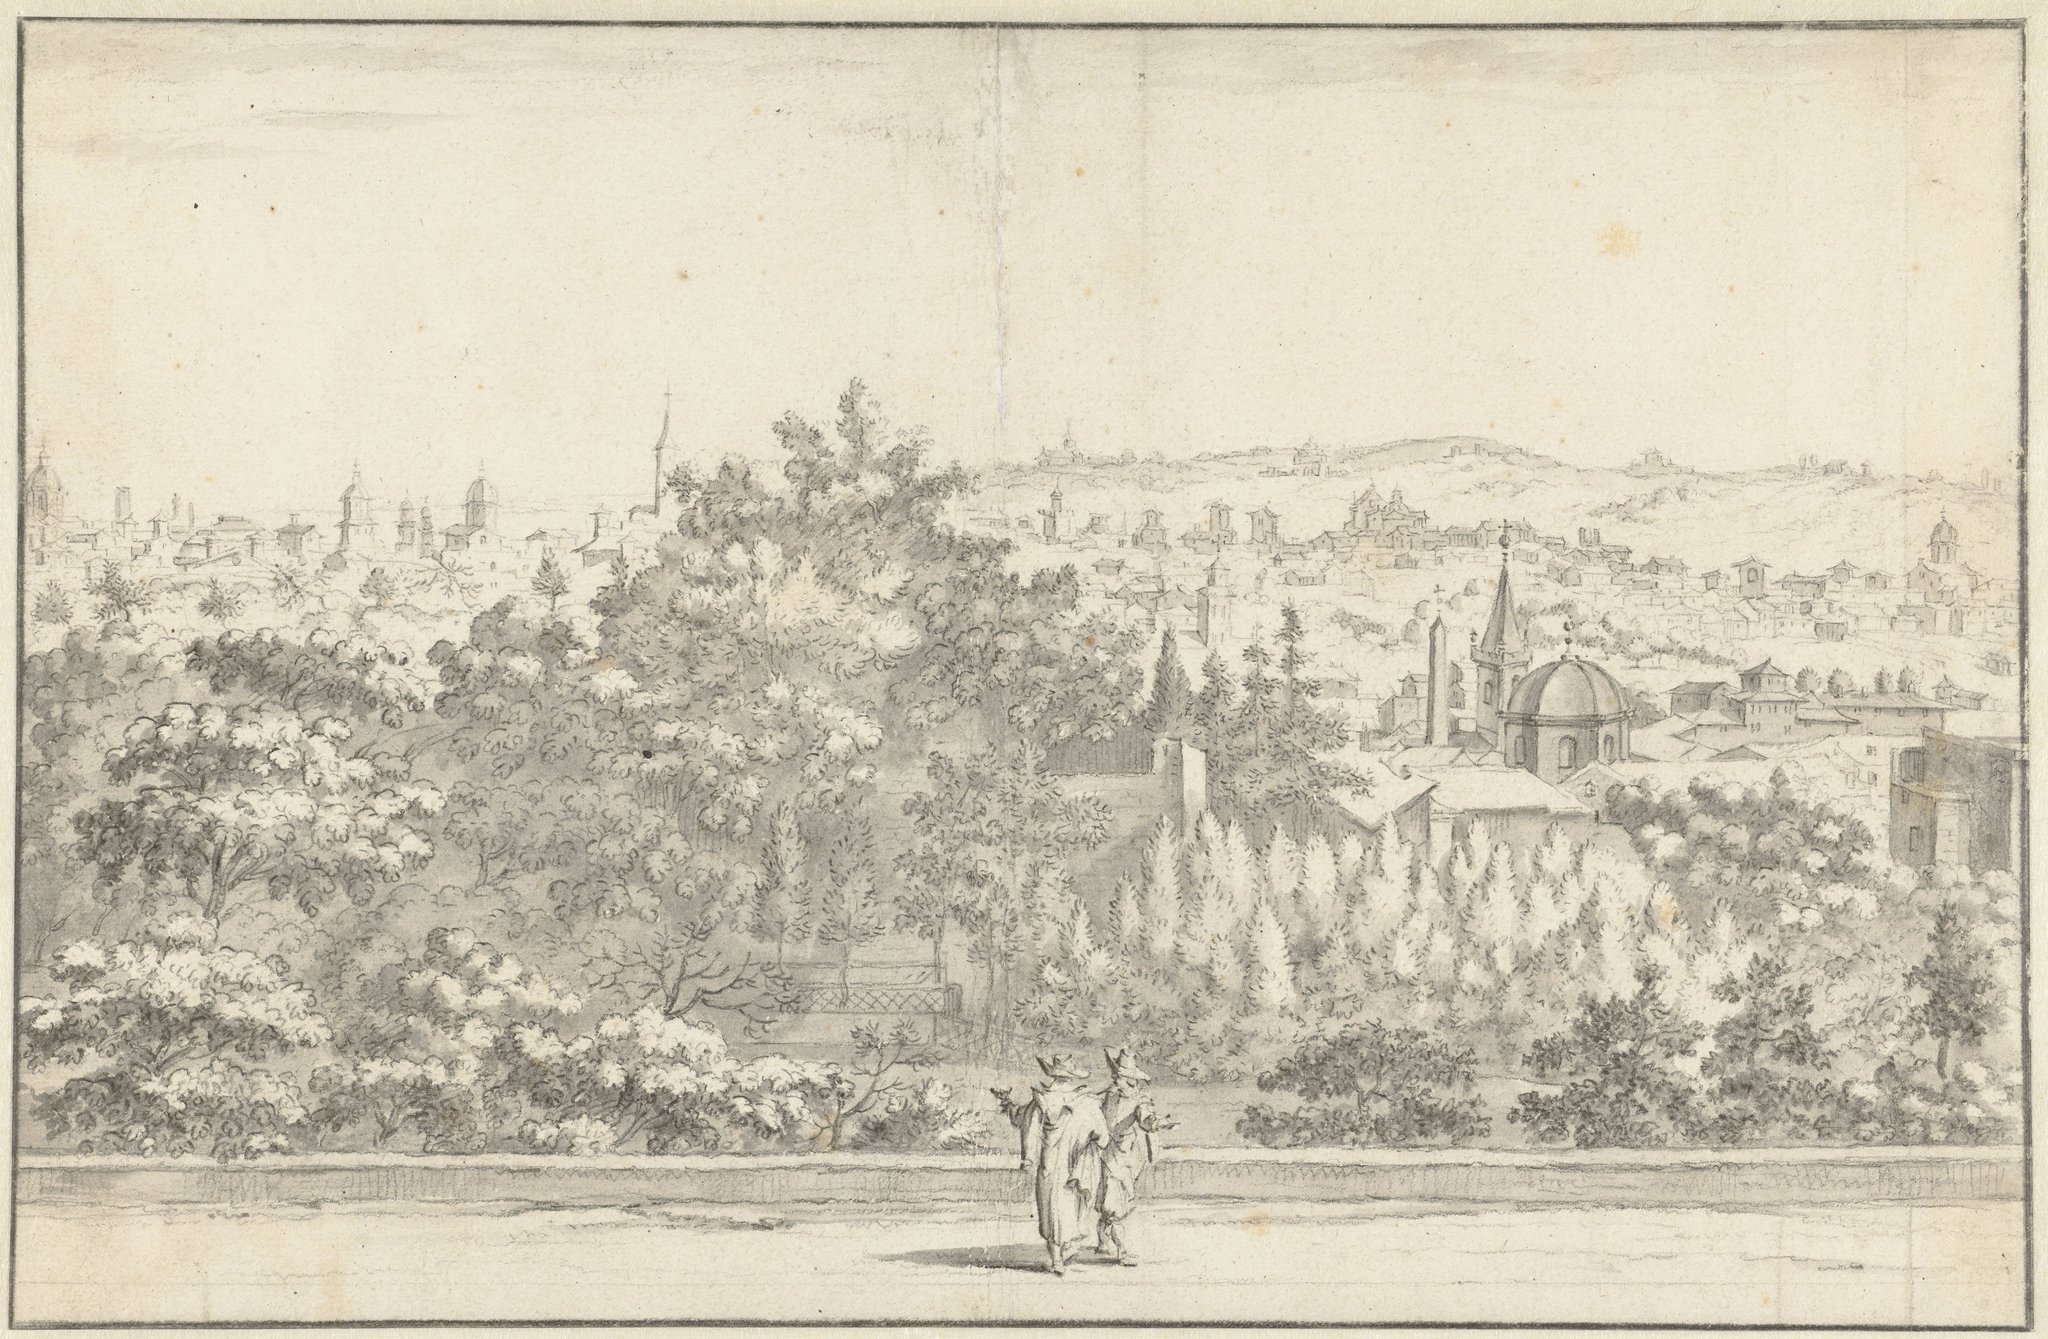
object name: drawing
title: Gezicht op een Italiaanse stad, op de voorgrond twee mannen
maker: theodor matham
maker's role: draughtsman, print maker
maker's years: 1605-1676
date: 1616-1660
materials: chalk, paper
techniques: brush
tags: prospect of city, town panorama, silhouette of city, italy